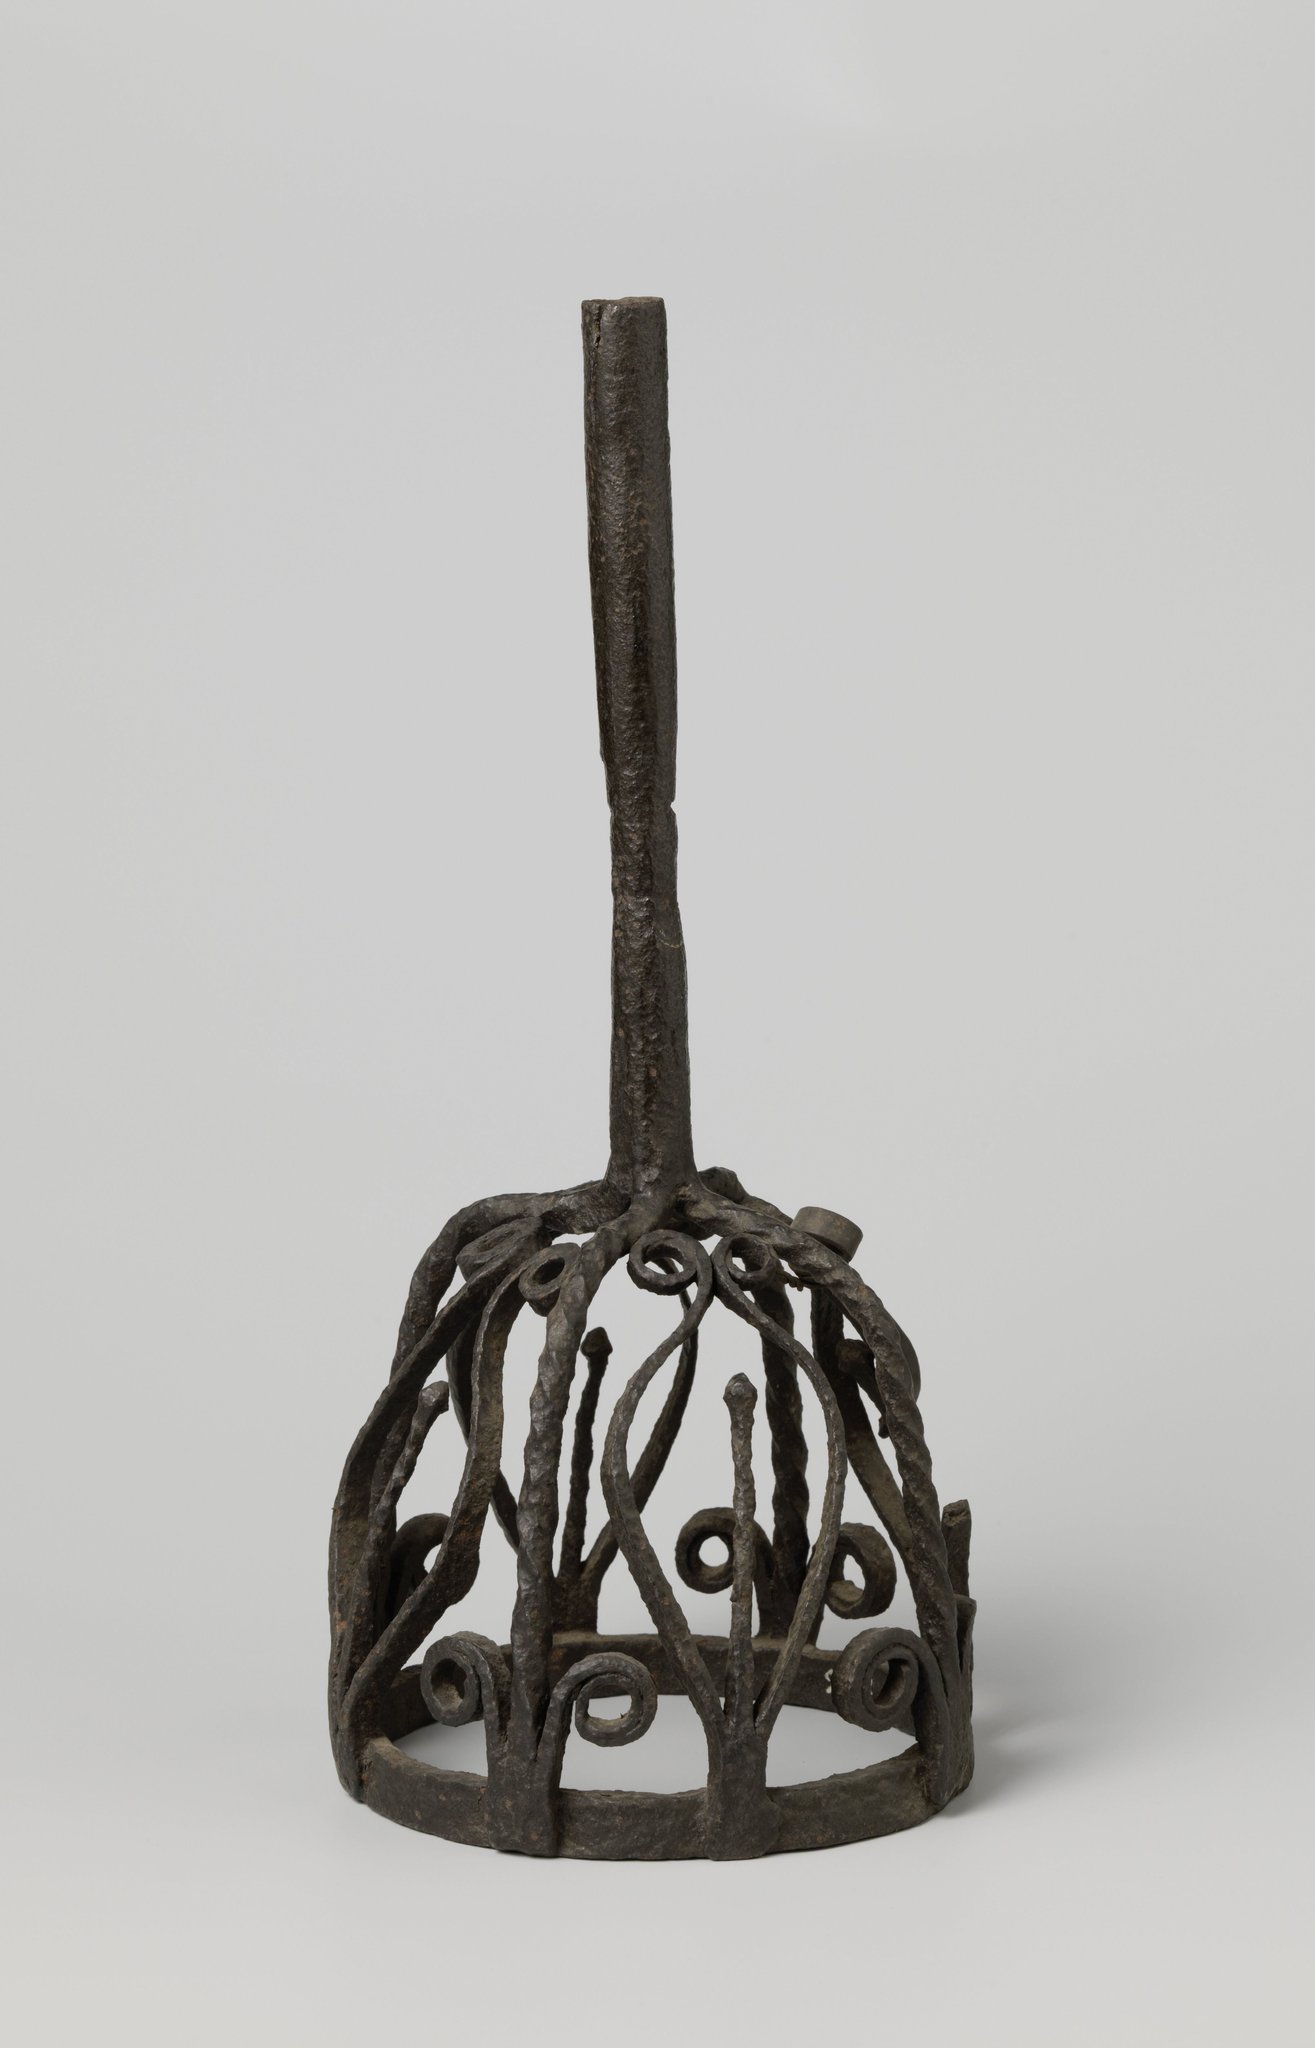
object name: stand support object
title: Standaard voor een vuurpot zonder voet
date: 1600-1699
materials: iron